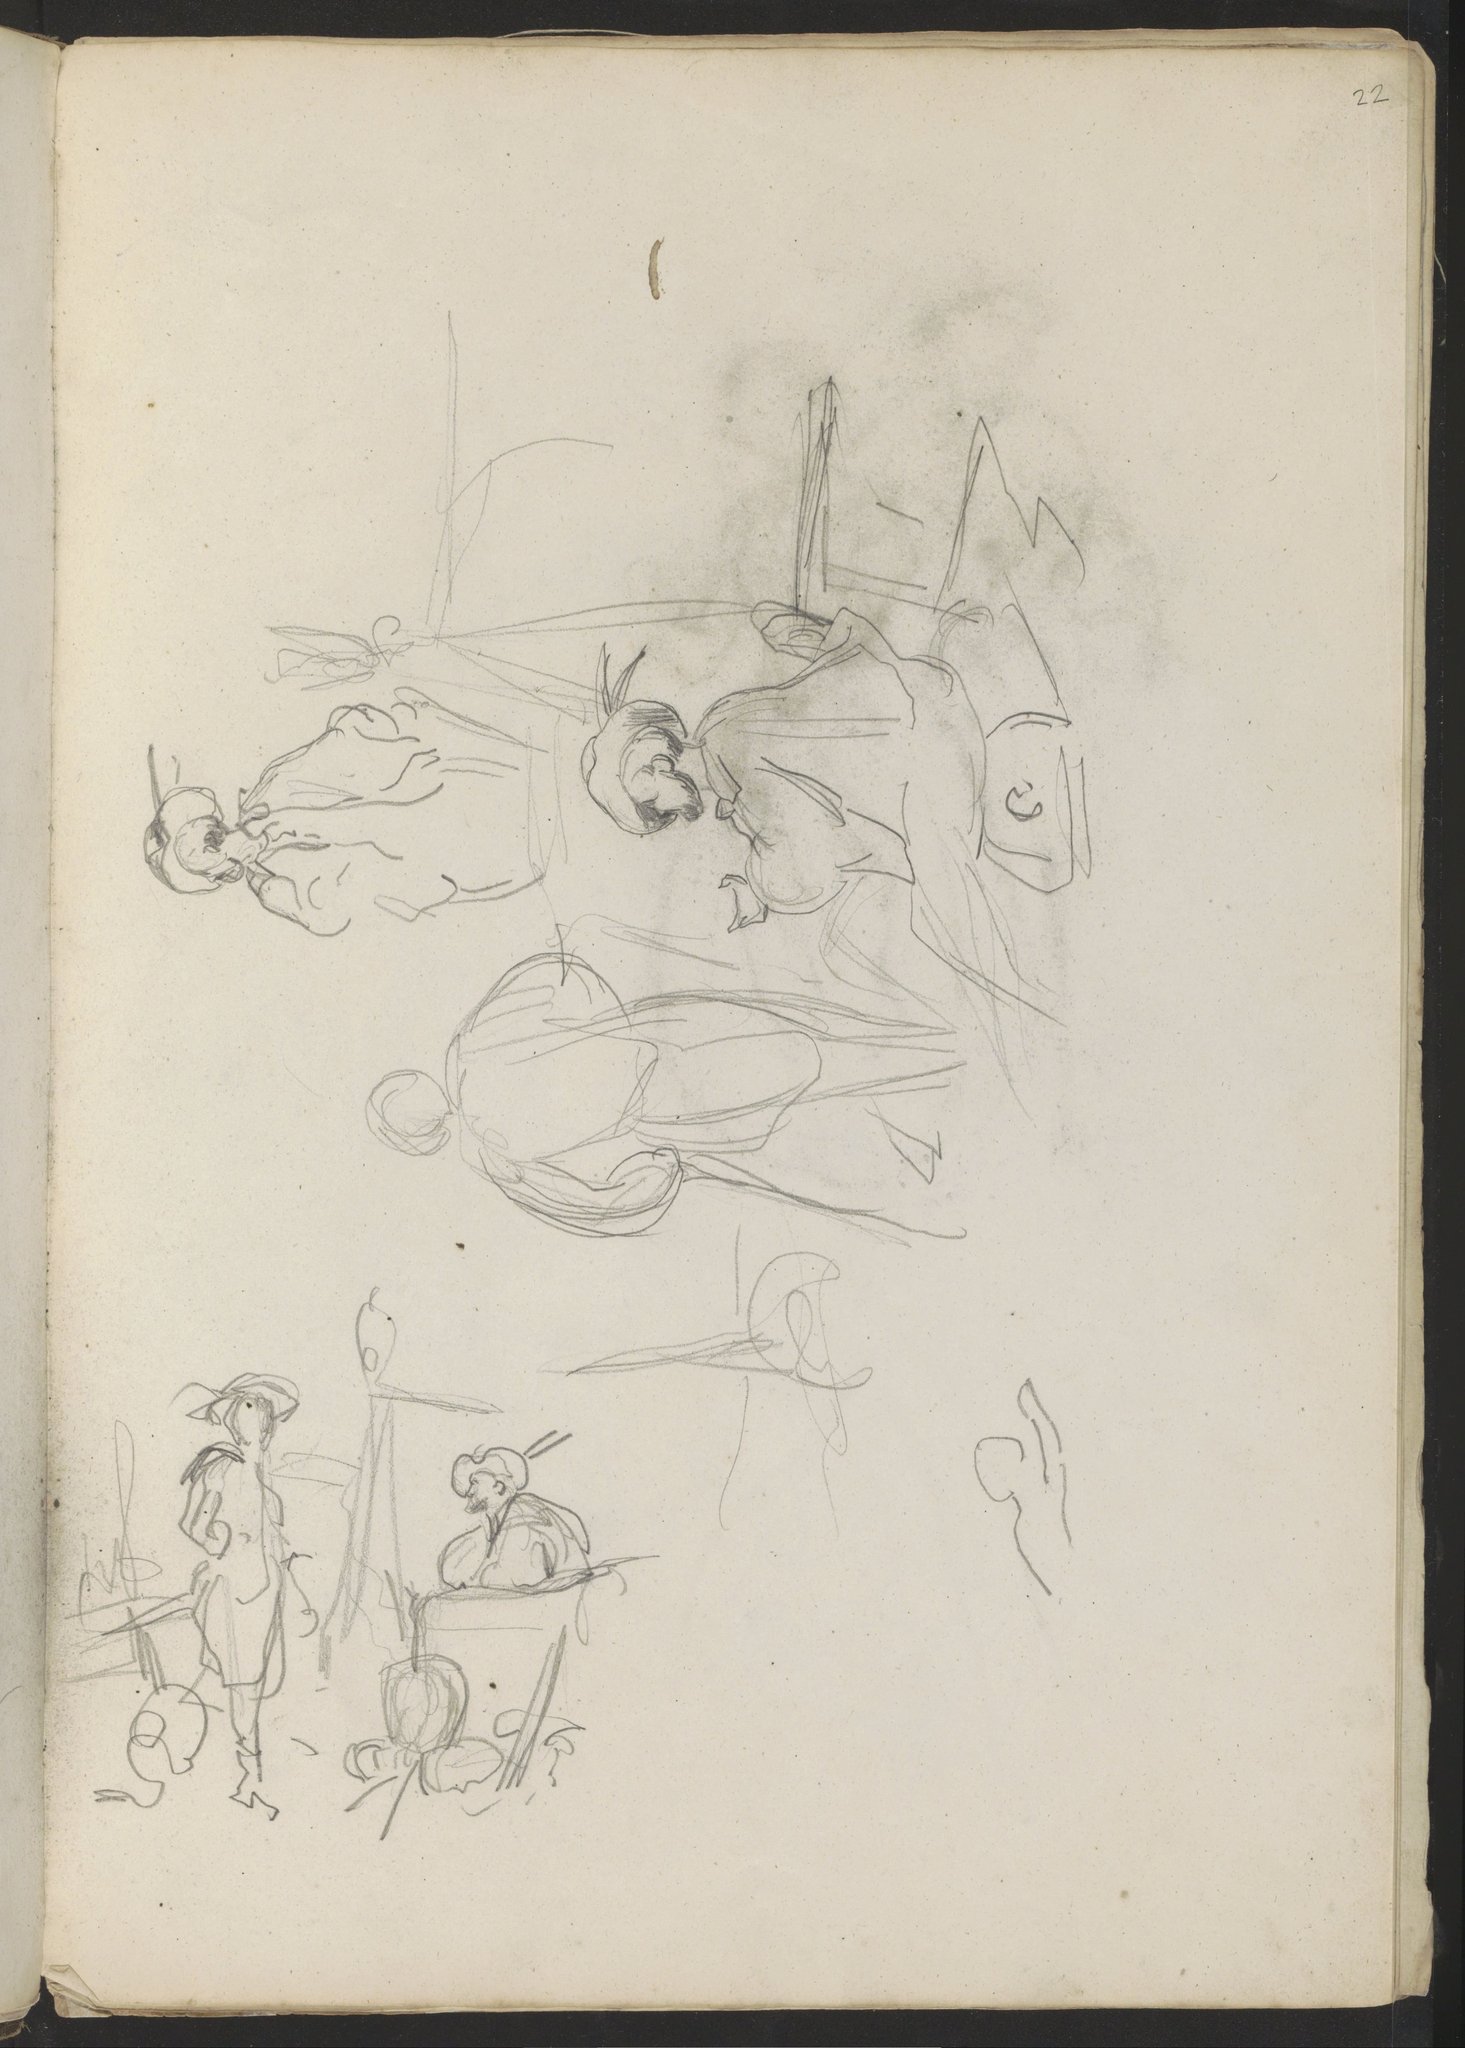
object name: sketchbook leaf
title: Mannen in zeventiende-eeuws kostuum, mogelijk bij een kade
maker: johannes huybertus van hove bzn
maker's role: print maker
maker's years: 1827-1881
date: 1837-1881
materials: paper, pencil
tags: historical costume (+ men's clothes), pier, quay, wharf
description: Blad 22 recto uit een schetsboek met 33 bladen en 10 losse tekeningen.